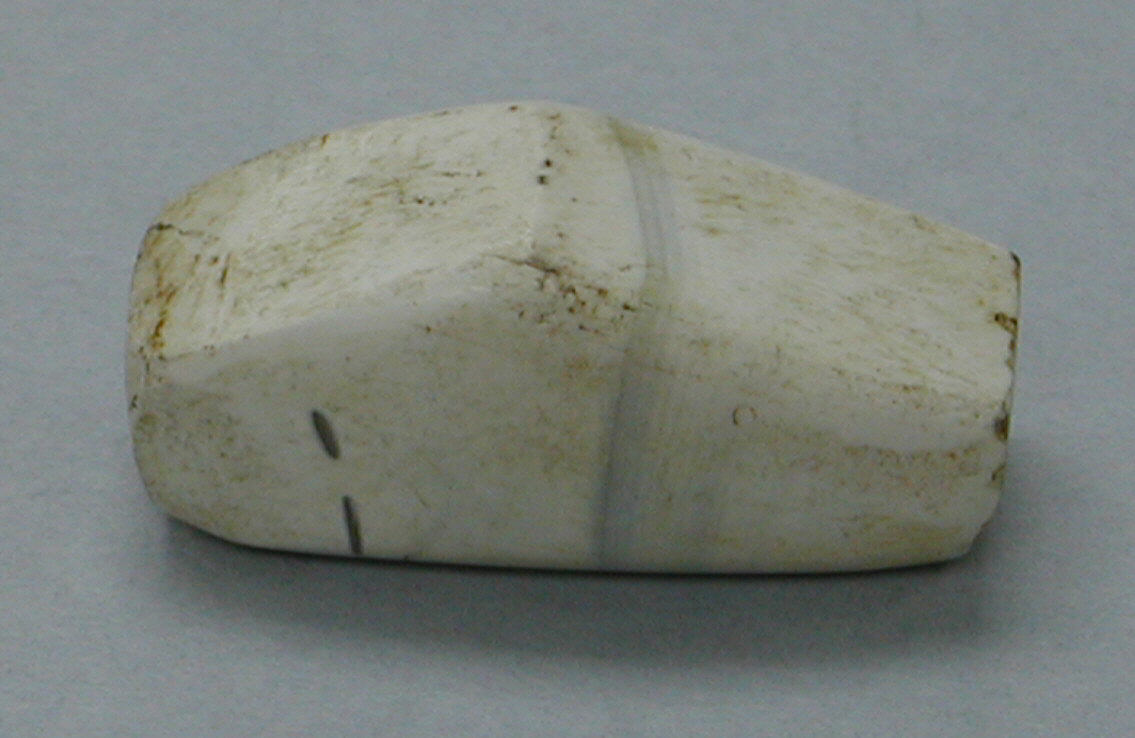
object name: ritual stone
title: Stone Pulidor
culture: mexican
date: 1501-1600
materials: stone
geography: mexico